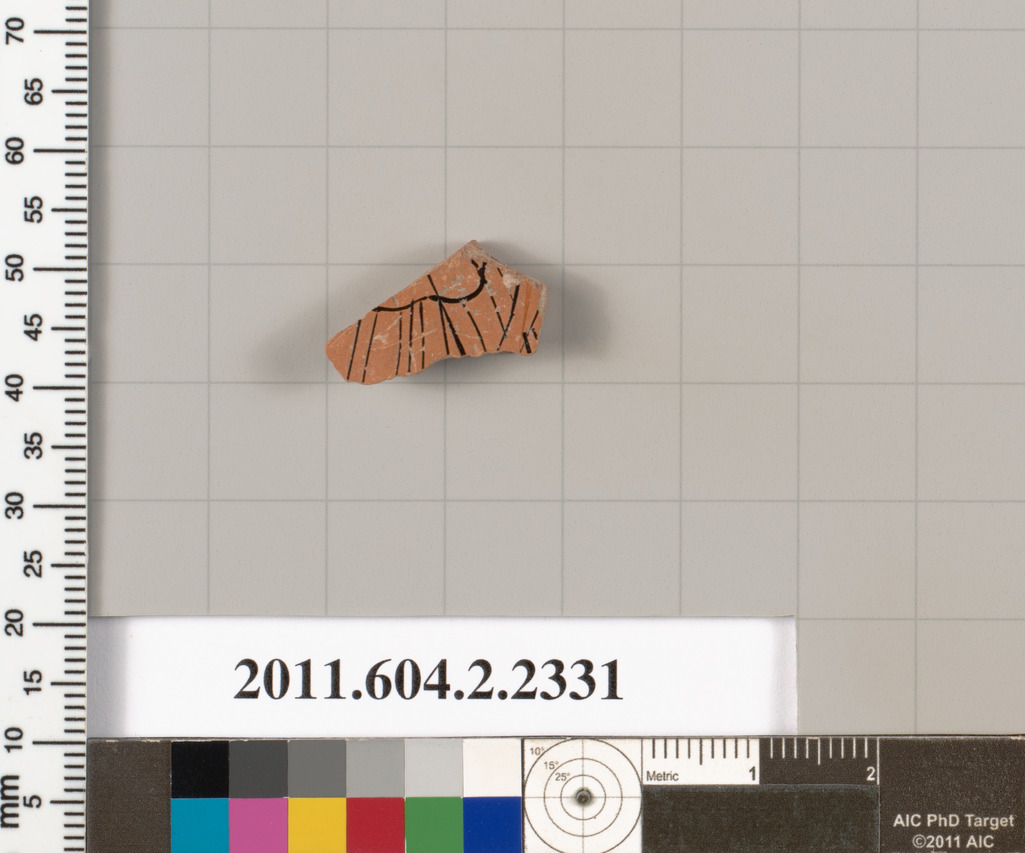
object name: skyphos fragment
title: Terracotta fragment of a skyphos (deep drinking cup)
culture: greek, attic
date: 490-470 BCE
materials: terracotta